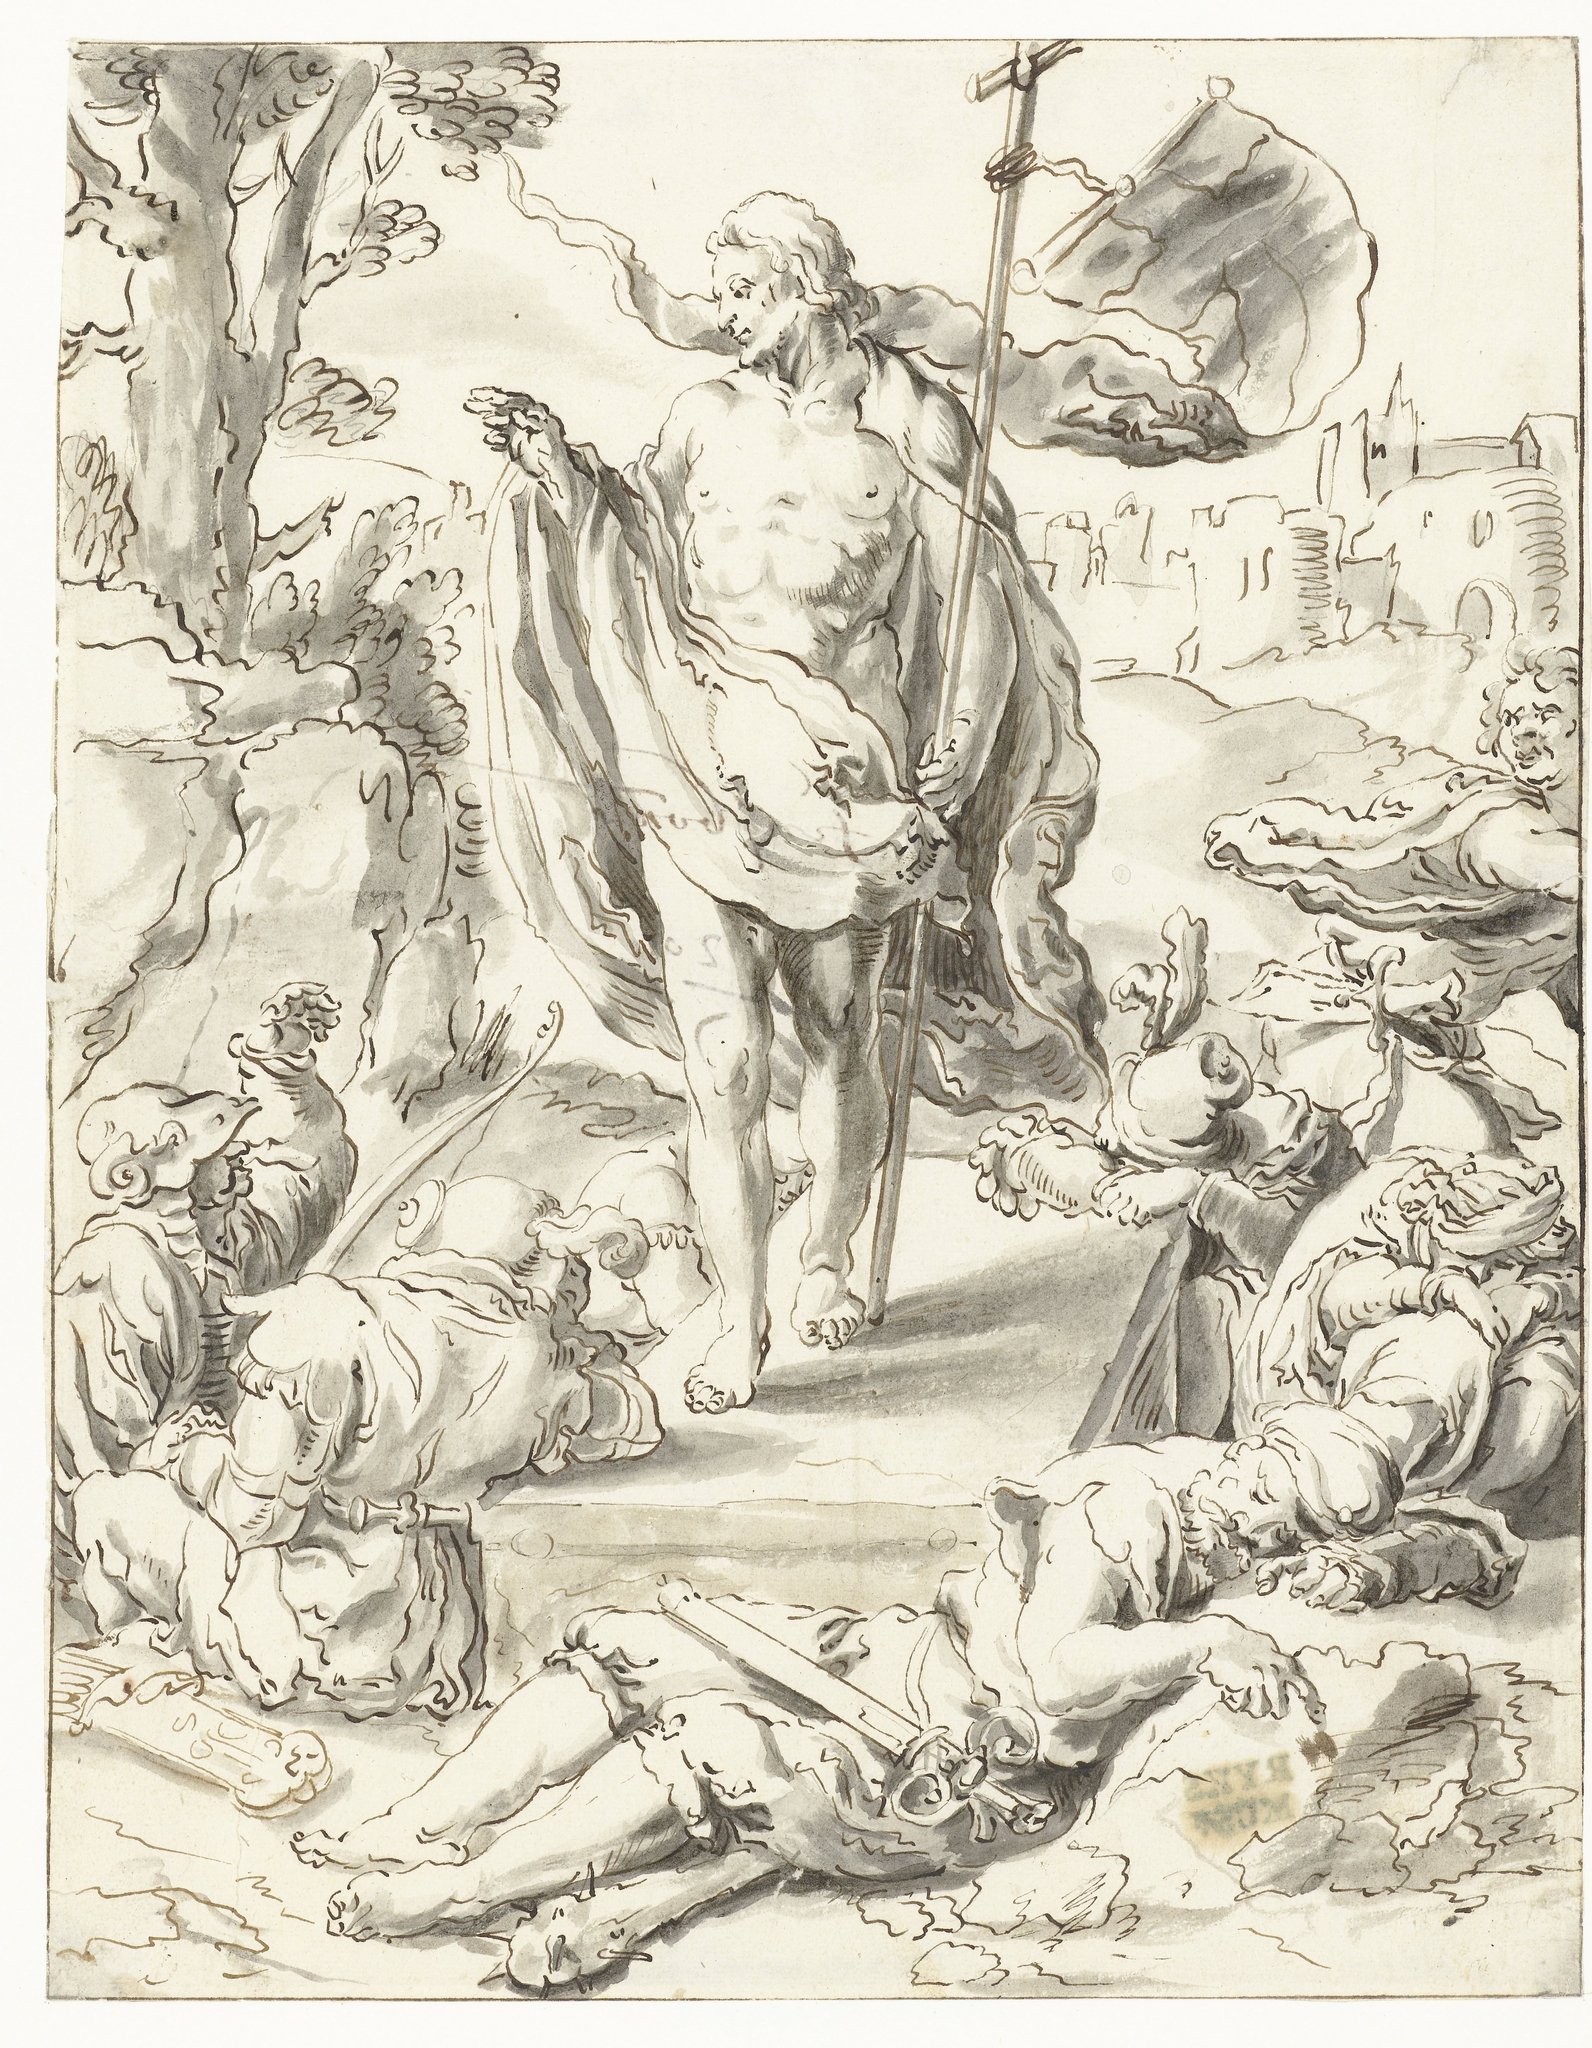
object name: drawing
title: Opstanding van Christus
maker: Anonymous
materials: chalk, ink, paper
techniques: brush, pen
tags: christ, usually holding a banner, arises from the grave; often combined with sleeping and/or frightened soldiers